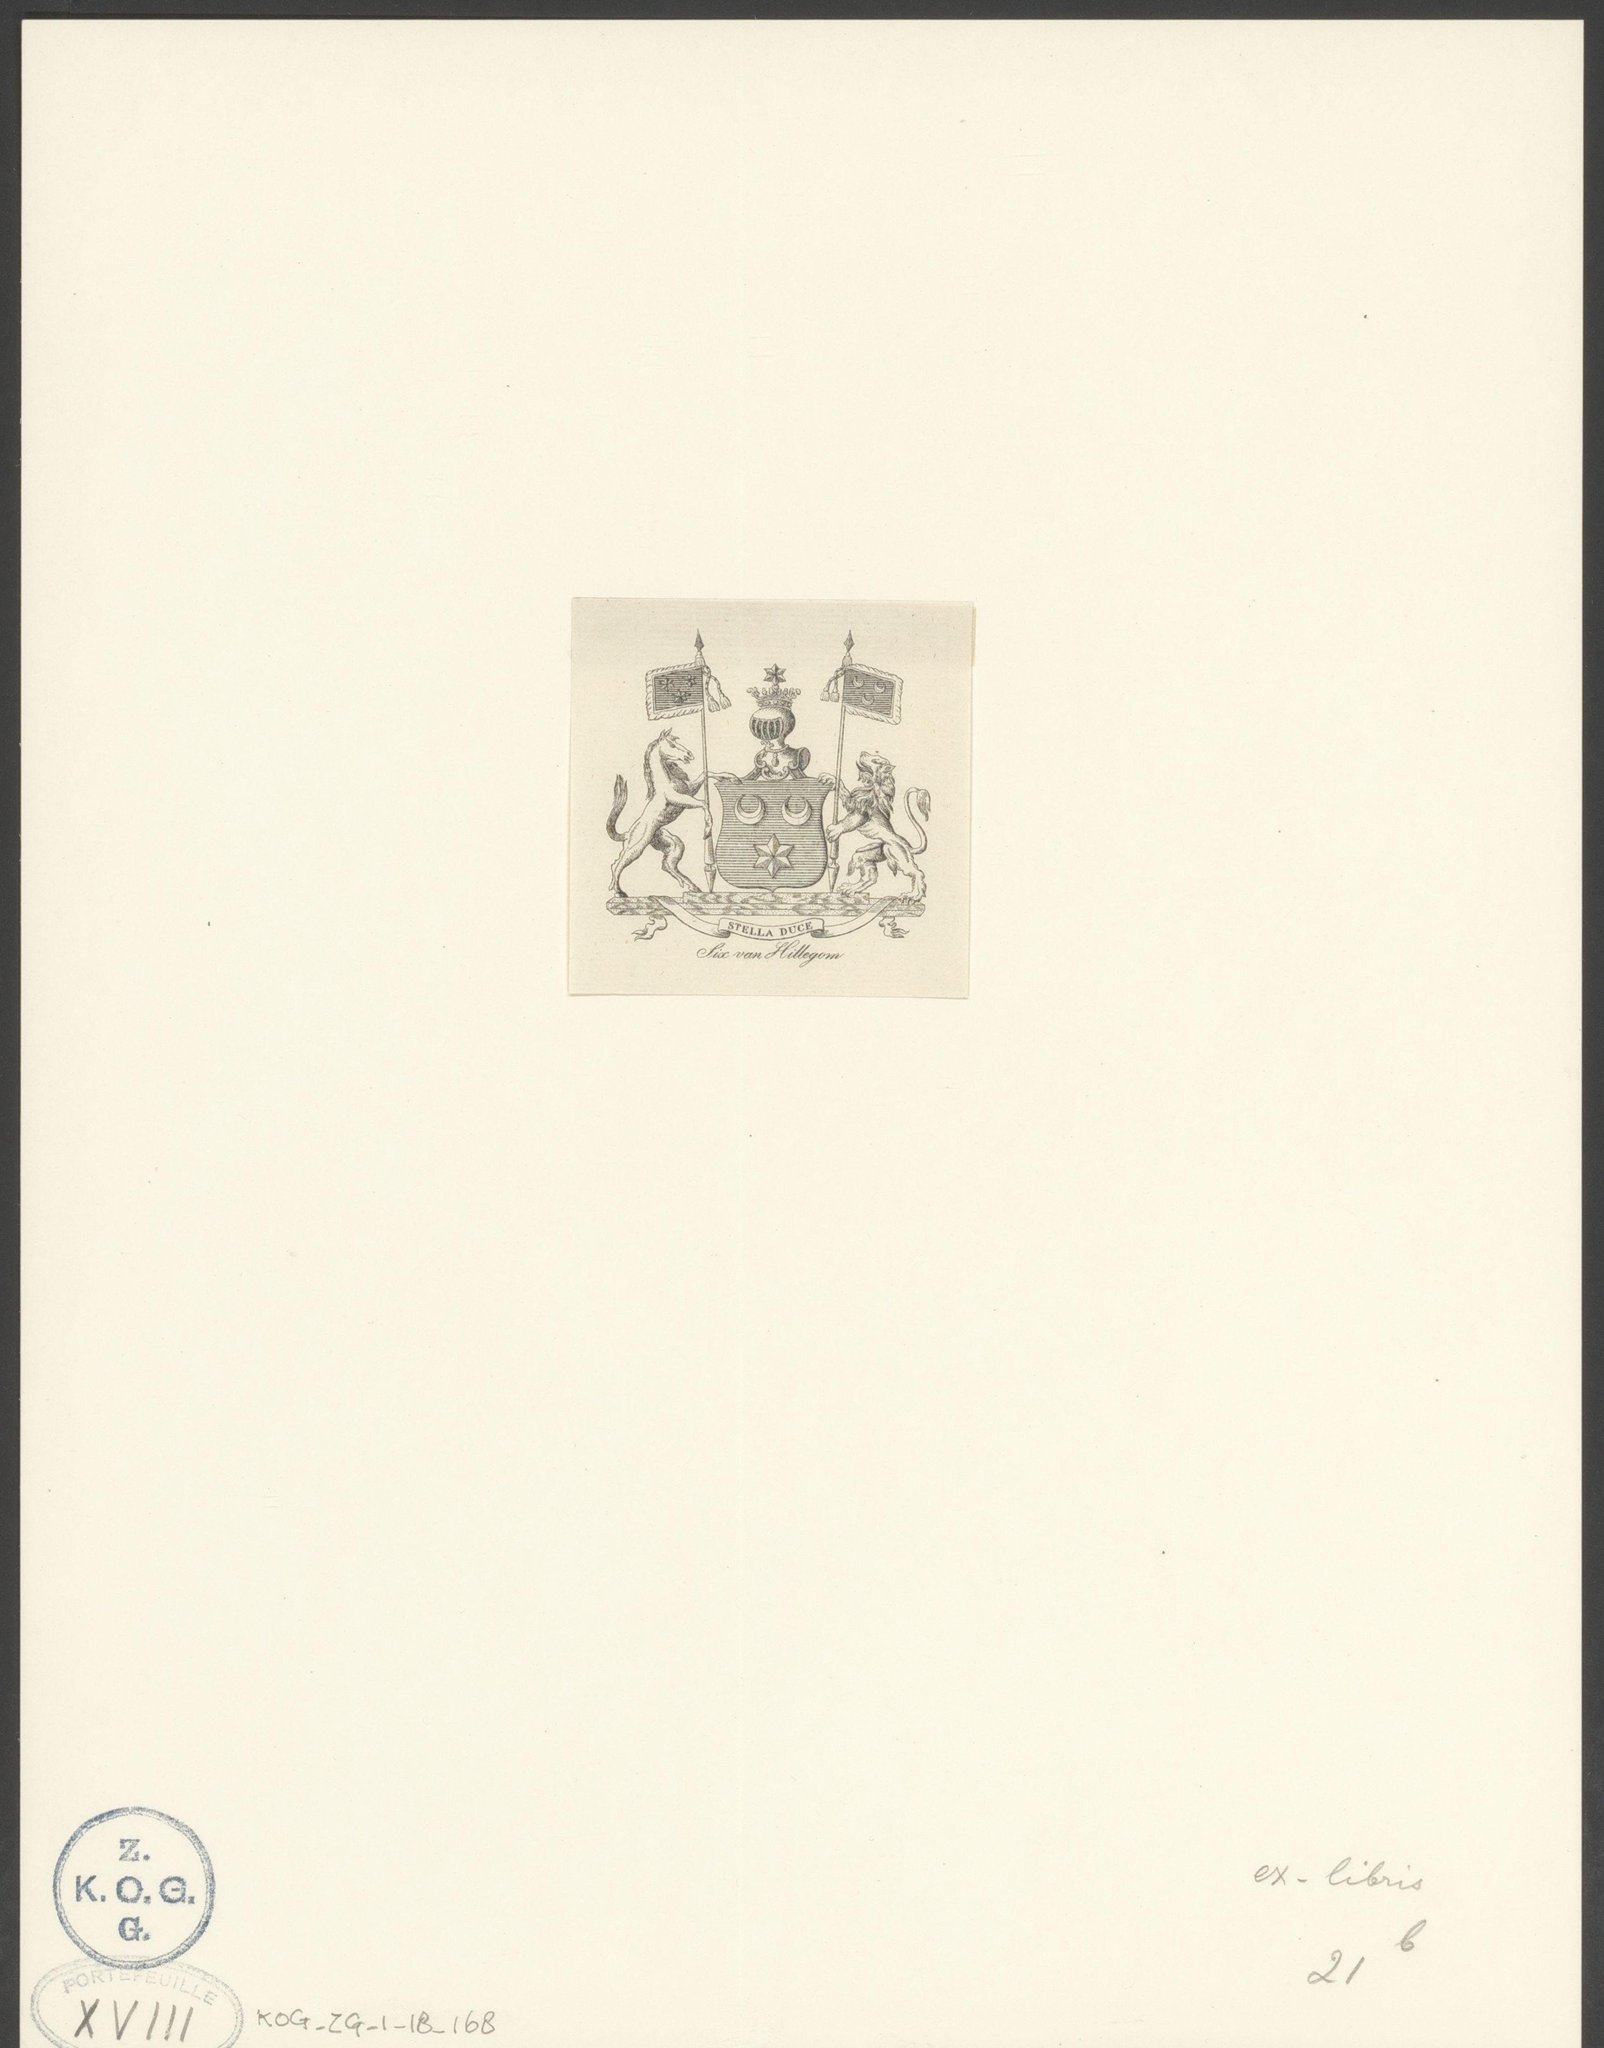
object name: bookplate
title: Wapenschild met twee manen en een ster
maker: Anonymous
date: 1893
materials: paper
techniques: etching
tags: ex-libris, armorial bearing, heraldry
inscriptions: collector's mark: Lugt 1641, stamp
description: Ex-libris van jonkheer Jan Pieter Six van Hillegom. Het gaat om een wapenschild met twee manen en een ster, bekroond met een helm en geflankeerd door links een paard en rechts een leeuw met een vaandel. Daaronder een banderol met de spreuk: Stella Duce.Ex-libris van jonkheer Jan Pieter Six van Hillegom. Het gaat om een wapenschild met twee manen en een ster, bekroond met een helm en geflankeerd door links een paard en rechts een leeuw met een vaandel. Daaronder een banderol met de spreuk: Stella Duce. Onderwerpsrubrieken binnen de Atlas Zeden en Gewoonten: Schoone kunsten, Ex-libris en gelegenheidsgrafiek.